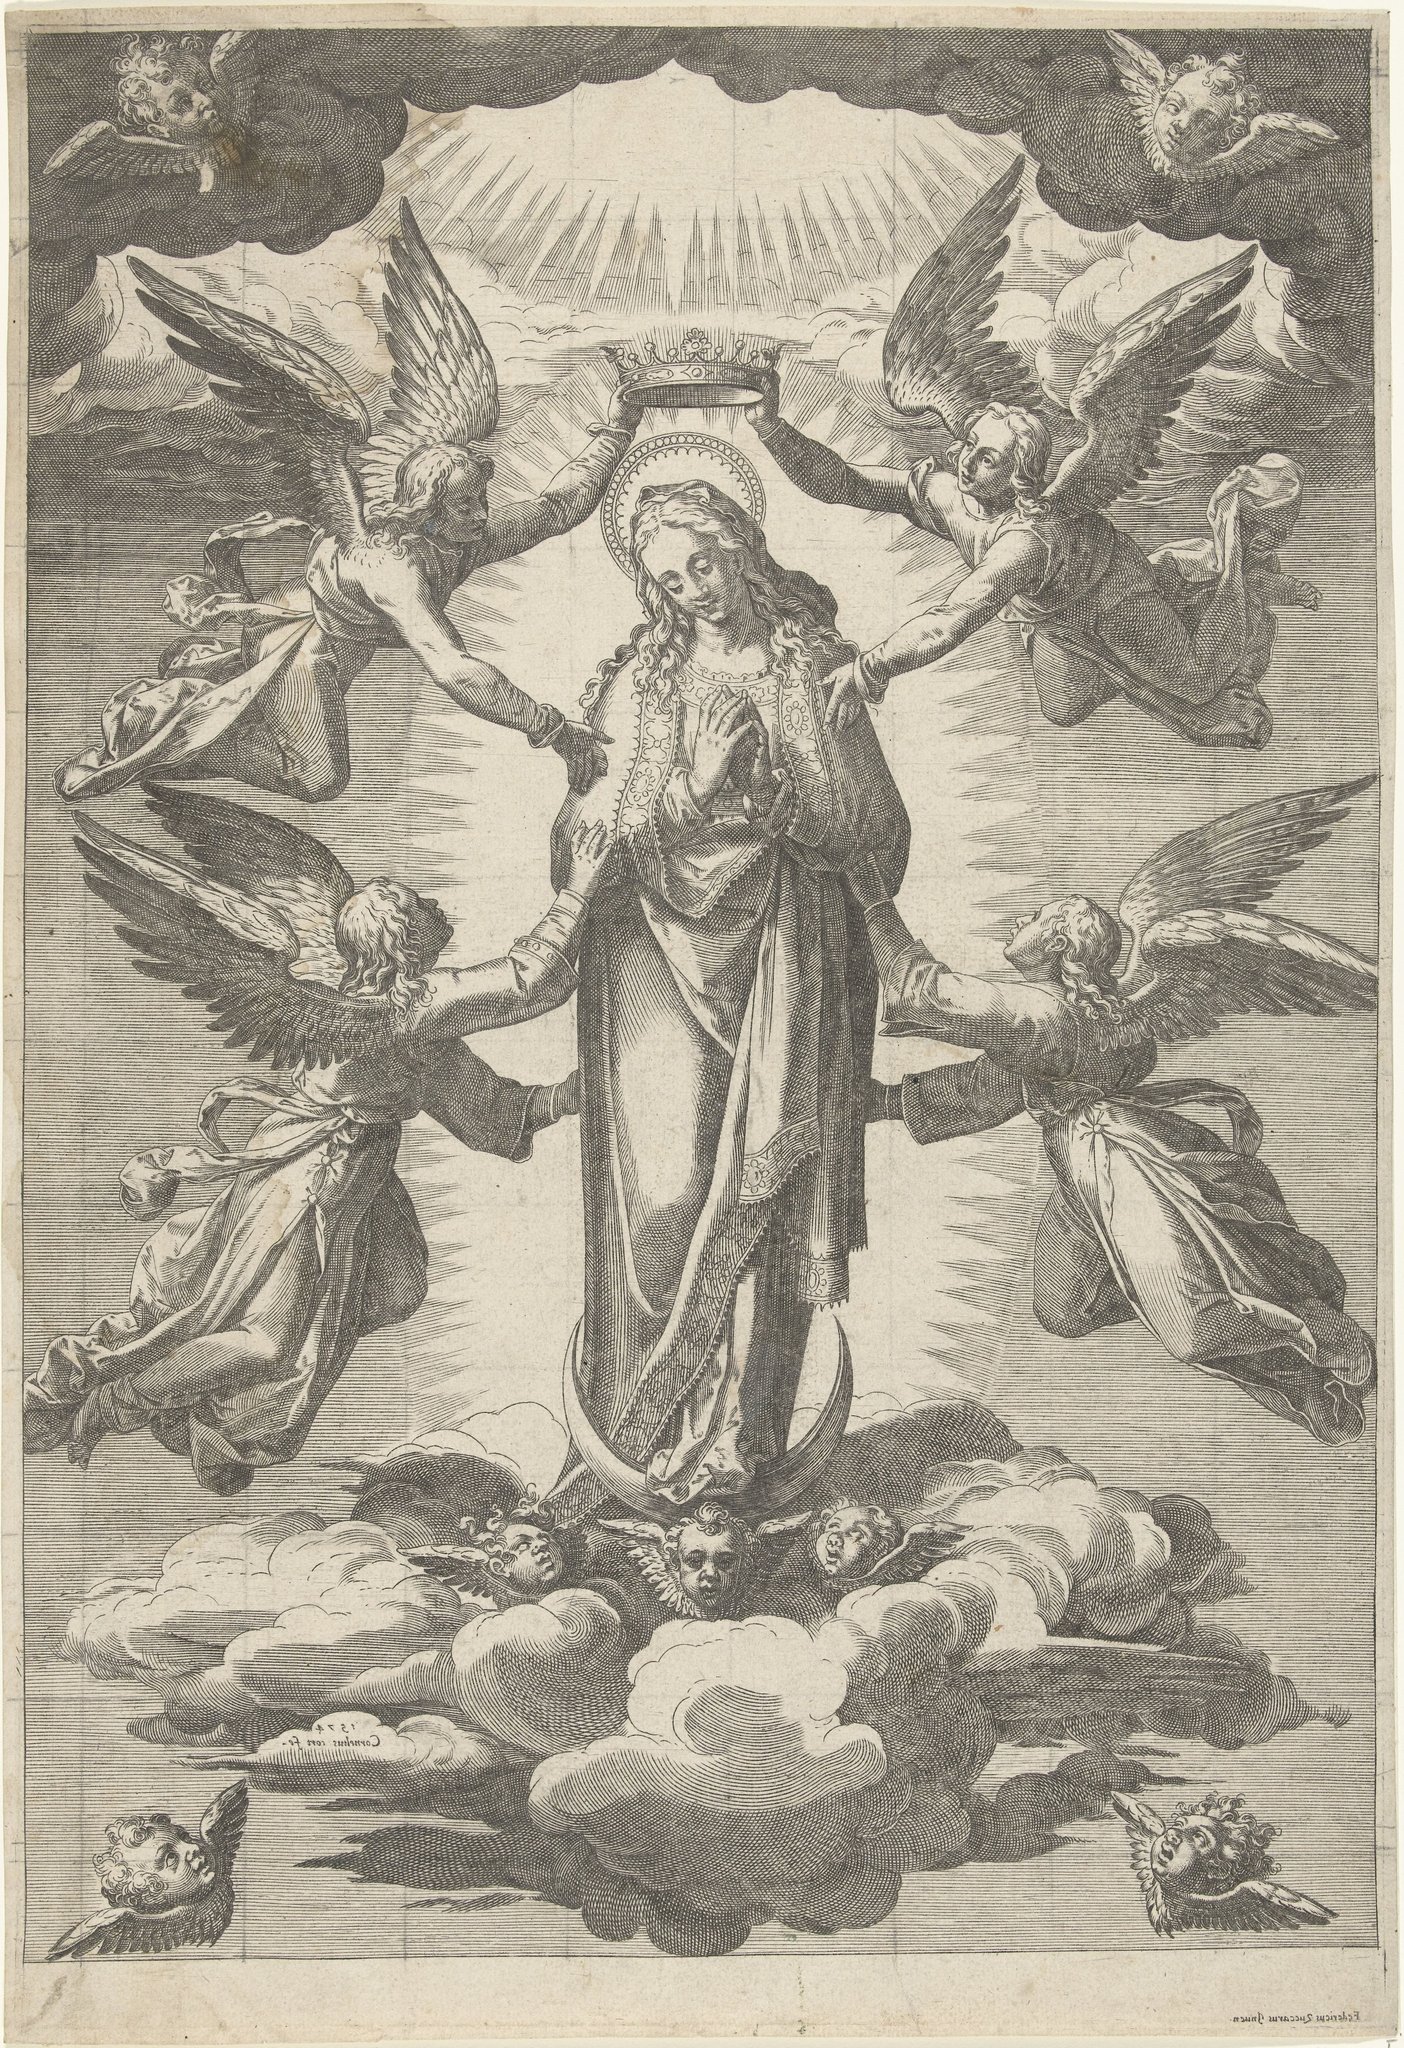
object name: print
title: Hemelvaart en kroning van Maria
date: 1574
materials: paper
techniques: printmaking, engraving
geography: rome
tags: assumption of mary combined with her coronation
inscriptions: collector's mark: Lugt 2228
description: Maria wordt door twee engelen gekroond. Twee andere engelen trekken haar de hemel in. Ze staat op een maansikkel in de wolken.